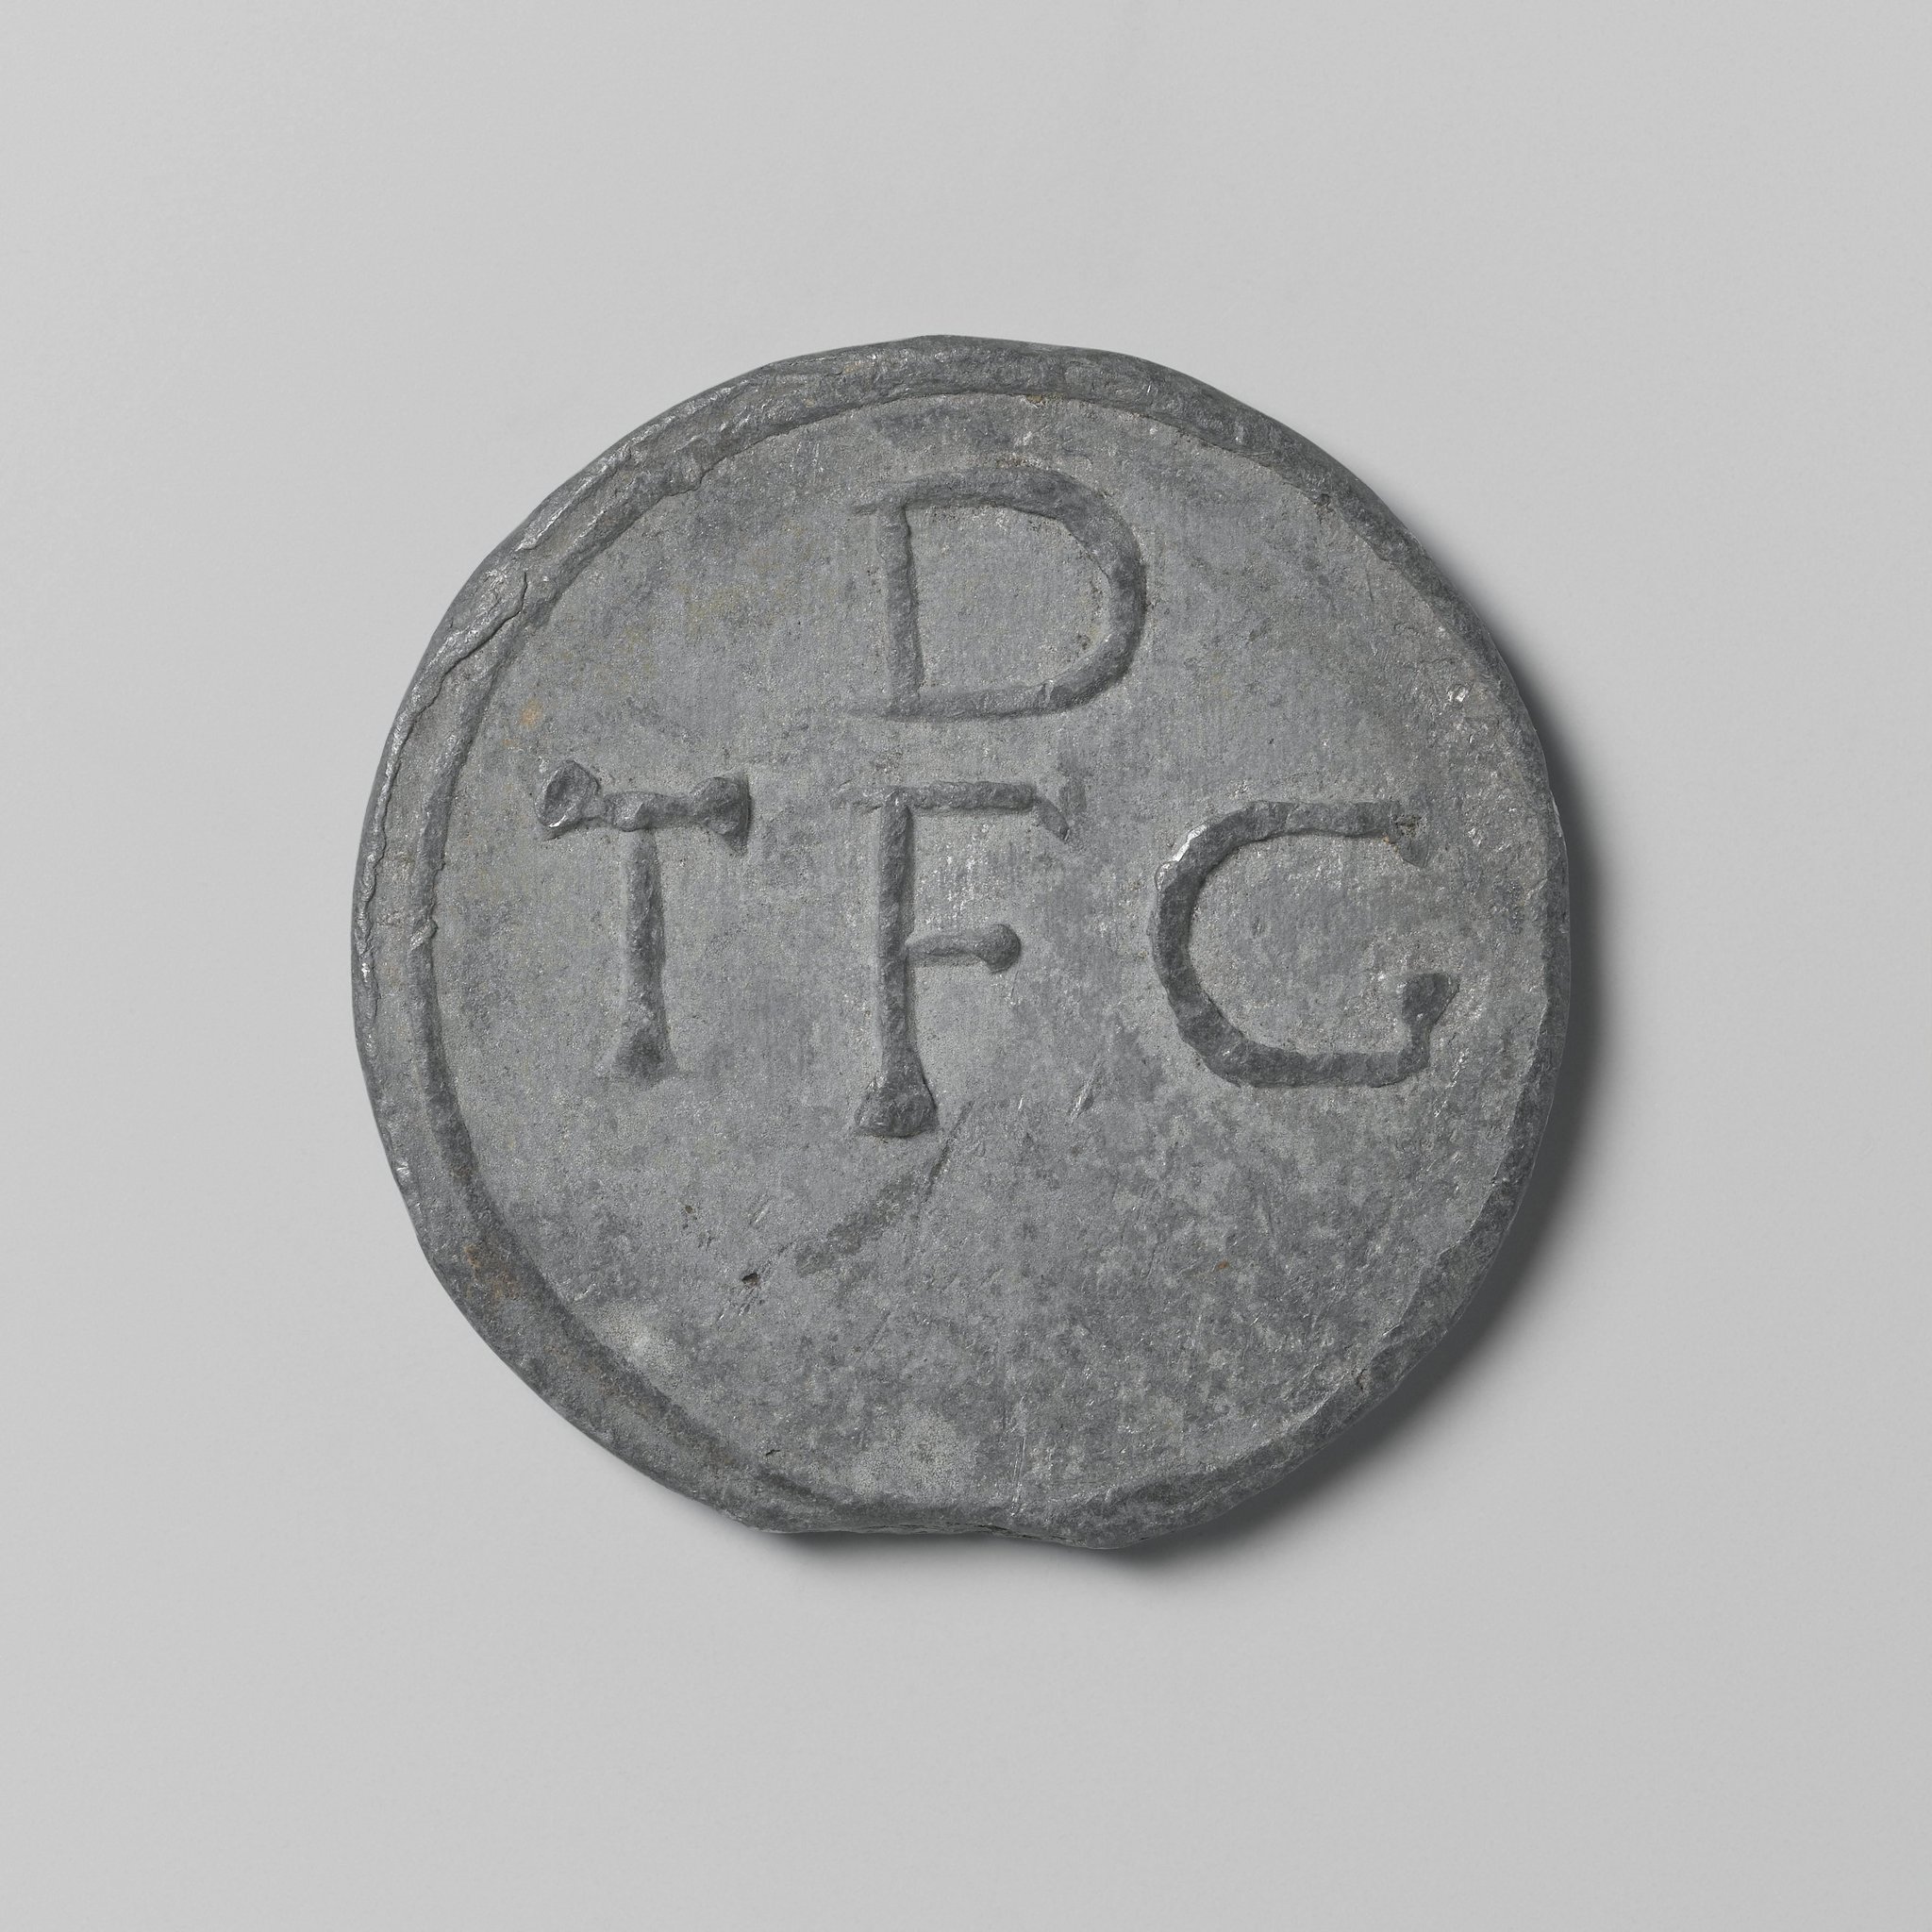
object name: medal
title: Turfdragersgilde van Amsterdam, presentiepenning met letter F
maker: Anonymous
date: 1600-1800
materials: lead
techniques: casting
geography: amsterdam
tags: amsterdam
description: Loden penning. Voorzijde: brandemmer. Keerzijde: letters T, D en G; onder D: letter F